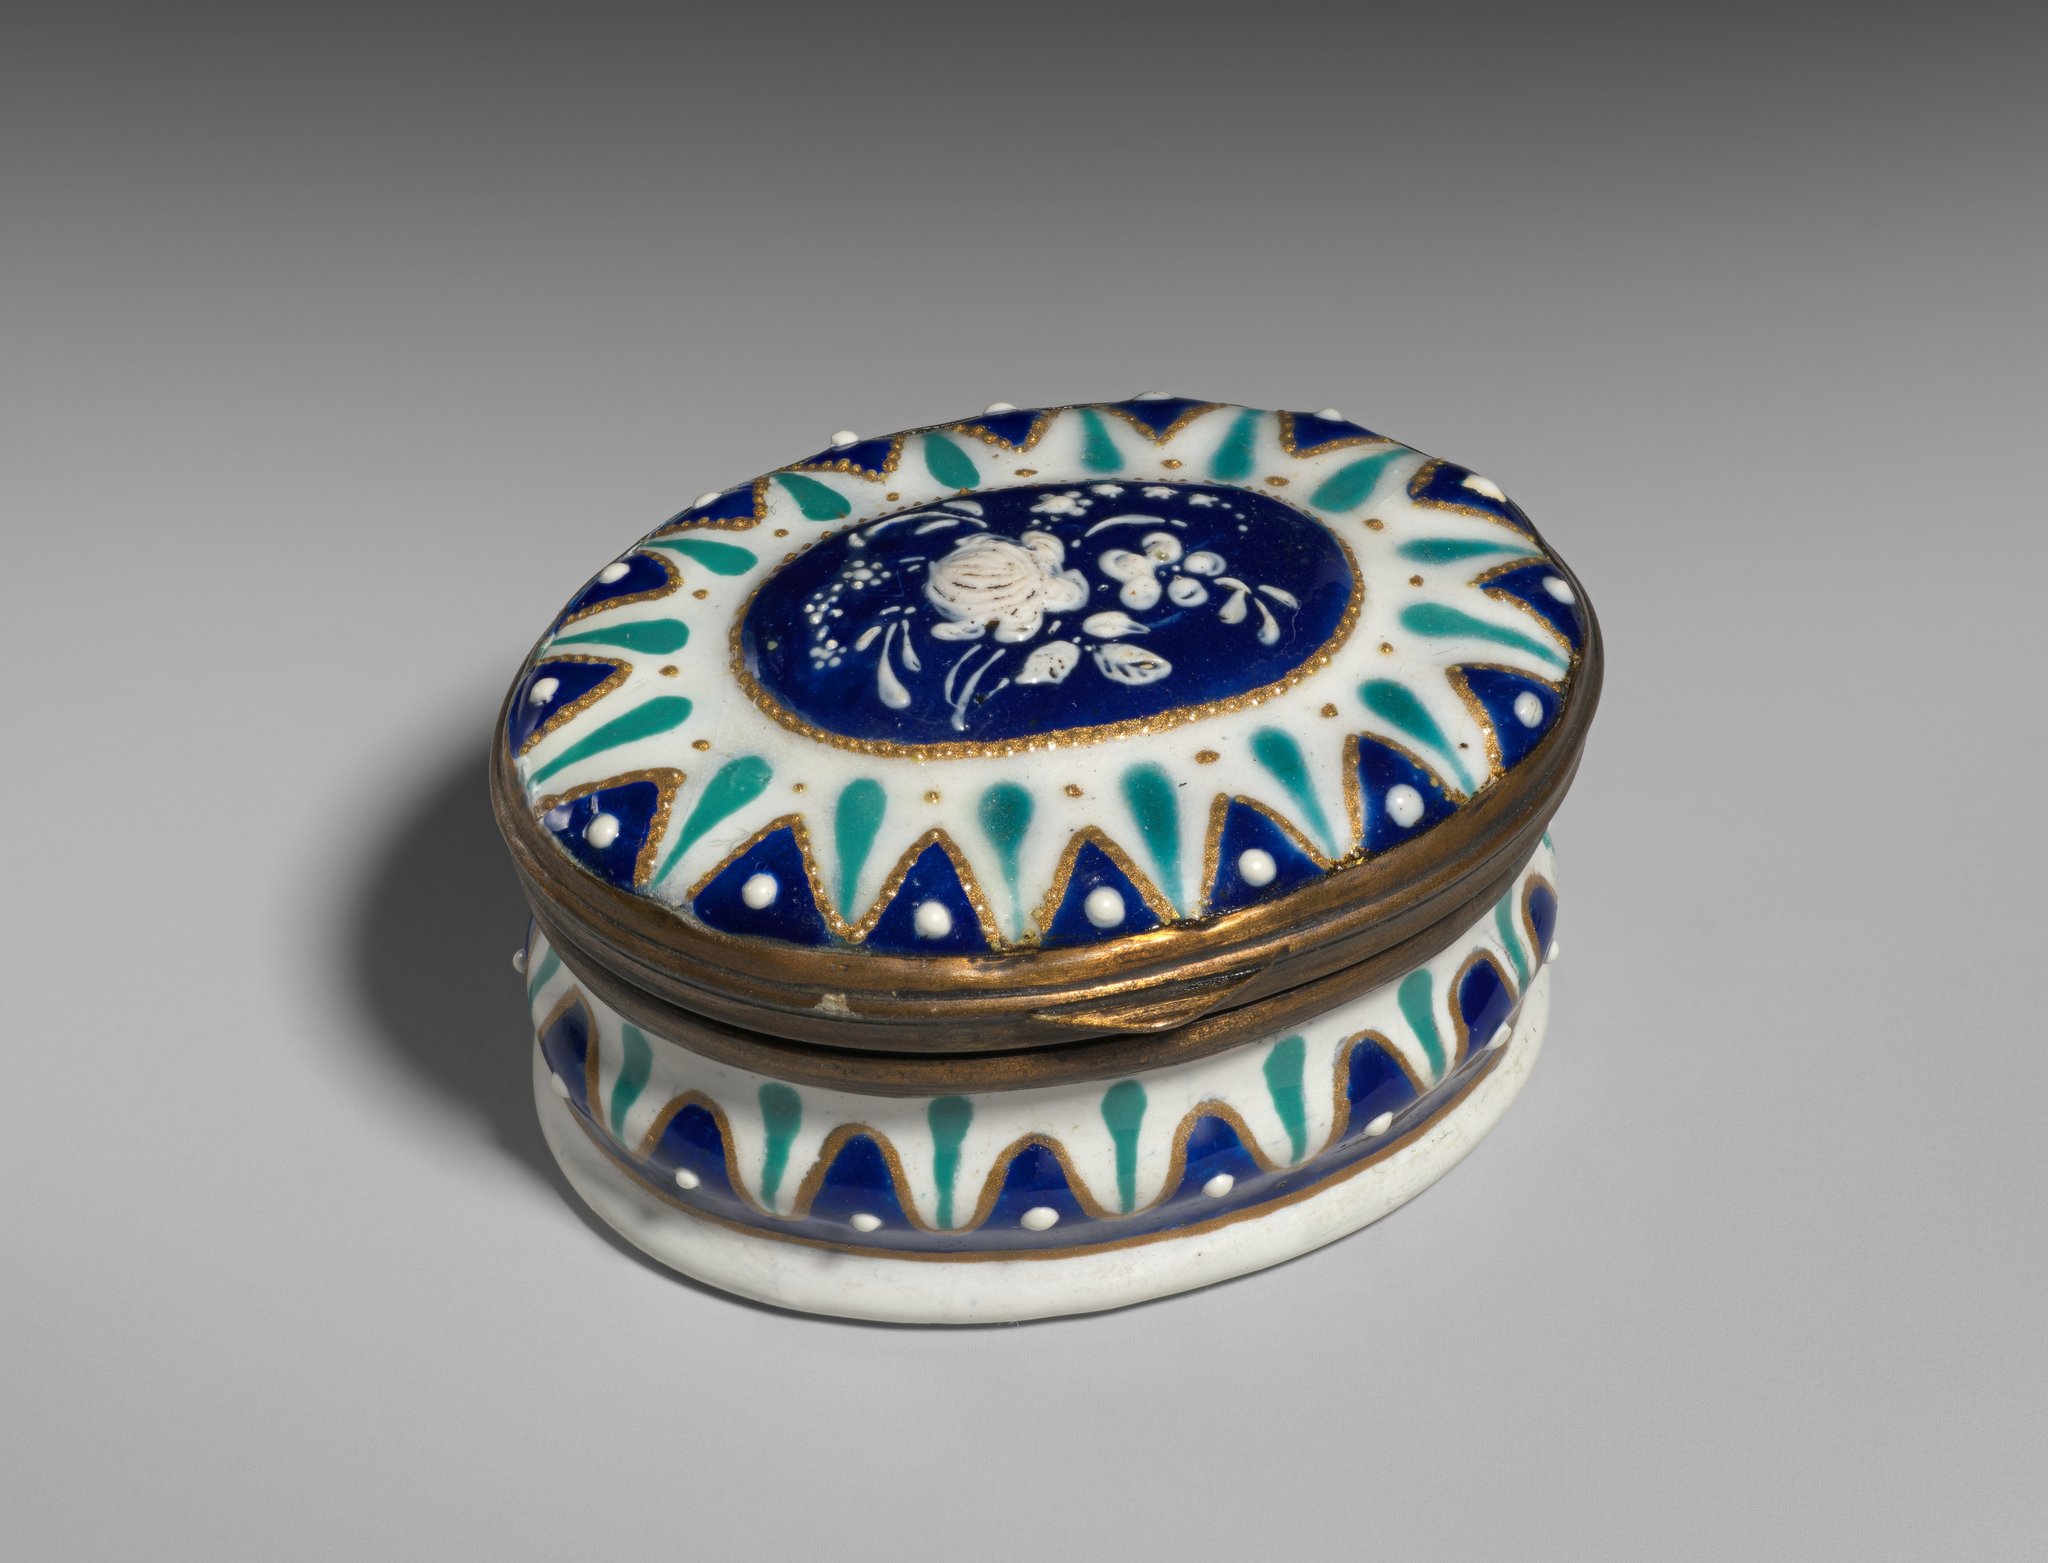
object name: patch box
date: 1770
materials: copper, enamel, glass